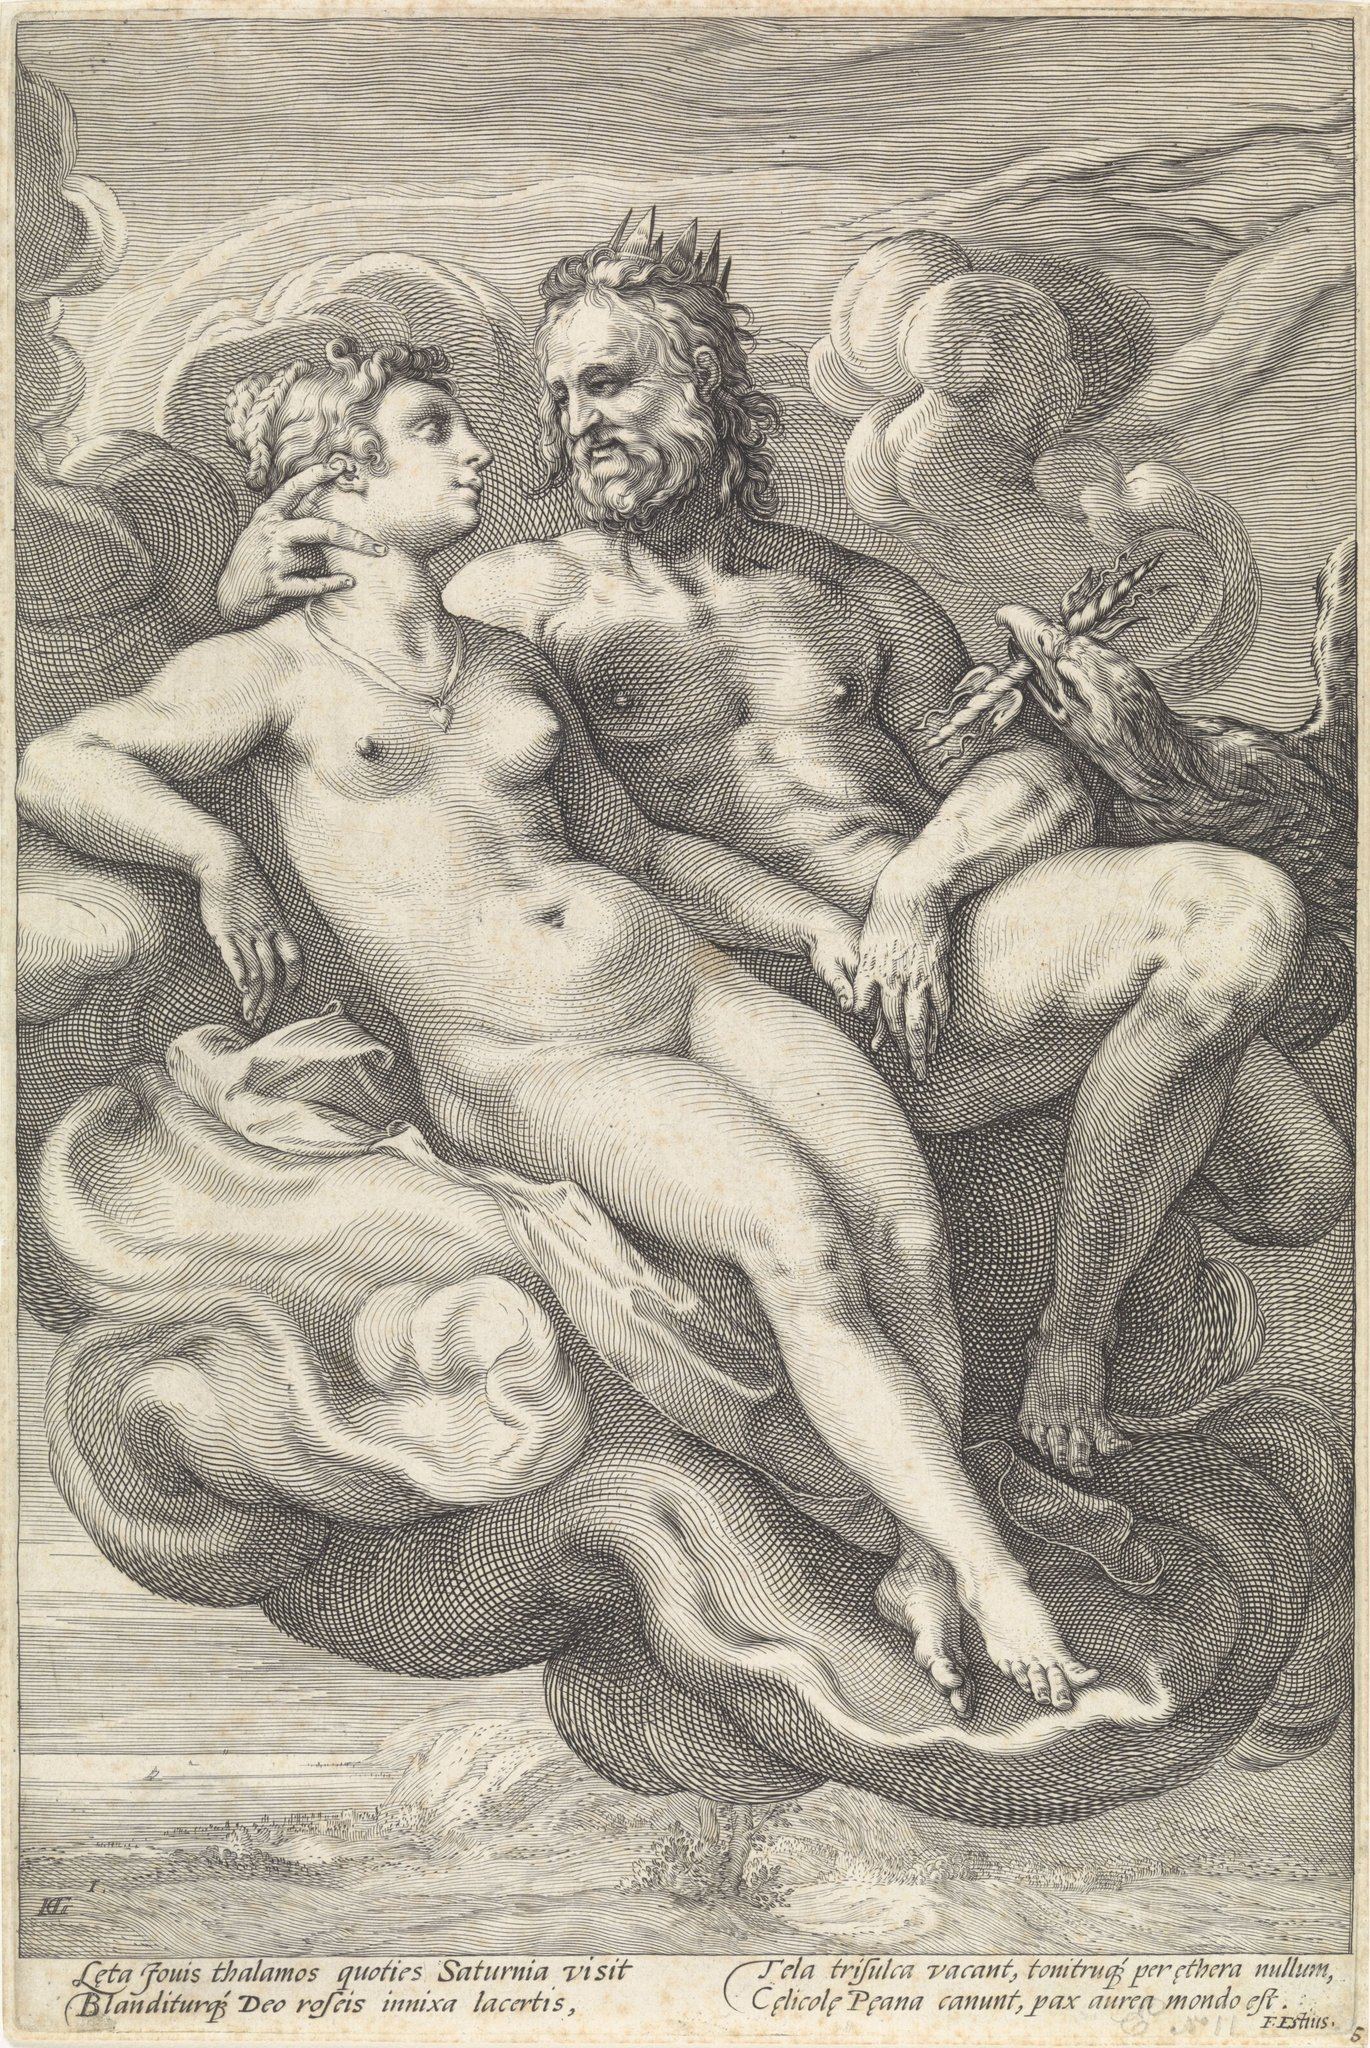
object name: print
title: Godenparen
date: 1575-1607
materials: paper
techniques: engraving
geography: haarlem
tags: jupiter and juno as lovers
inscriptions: number: ‘5’, collector's mark: Lugt 11, collector's mark: Lugt 10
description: De naakte Jupiter en Juno samen op een wolk in de lucht. Ze omhelzen elkaar. Aan Jupiters zijde zit de adelaar, de vogel die aan hem is gewijd. Deze houdt een bliksemschicht in zijn snavel, die de heerschappij van Jupiter over het licht symboliseert.De prent is deel van een serie van godenparen en heeft een Latijns onderschrift.